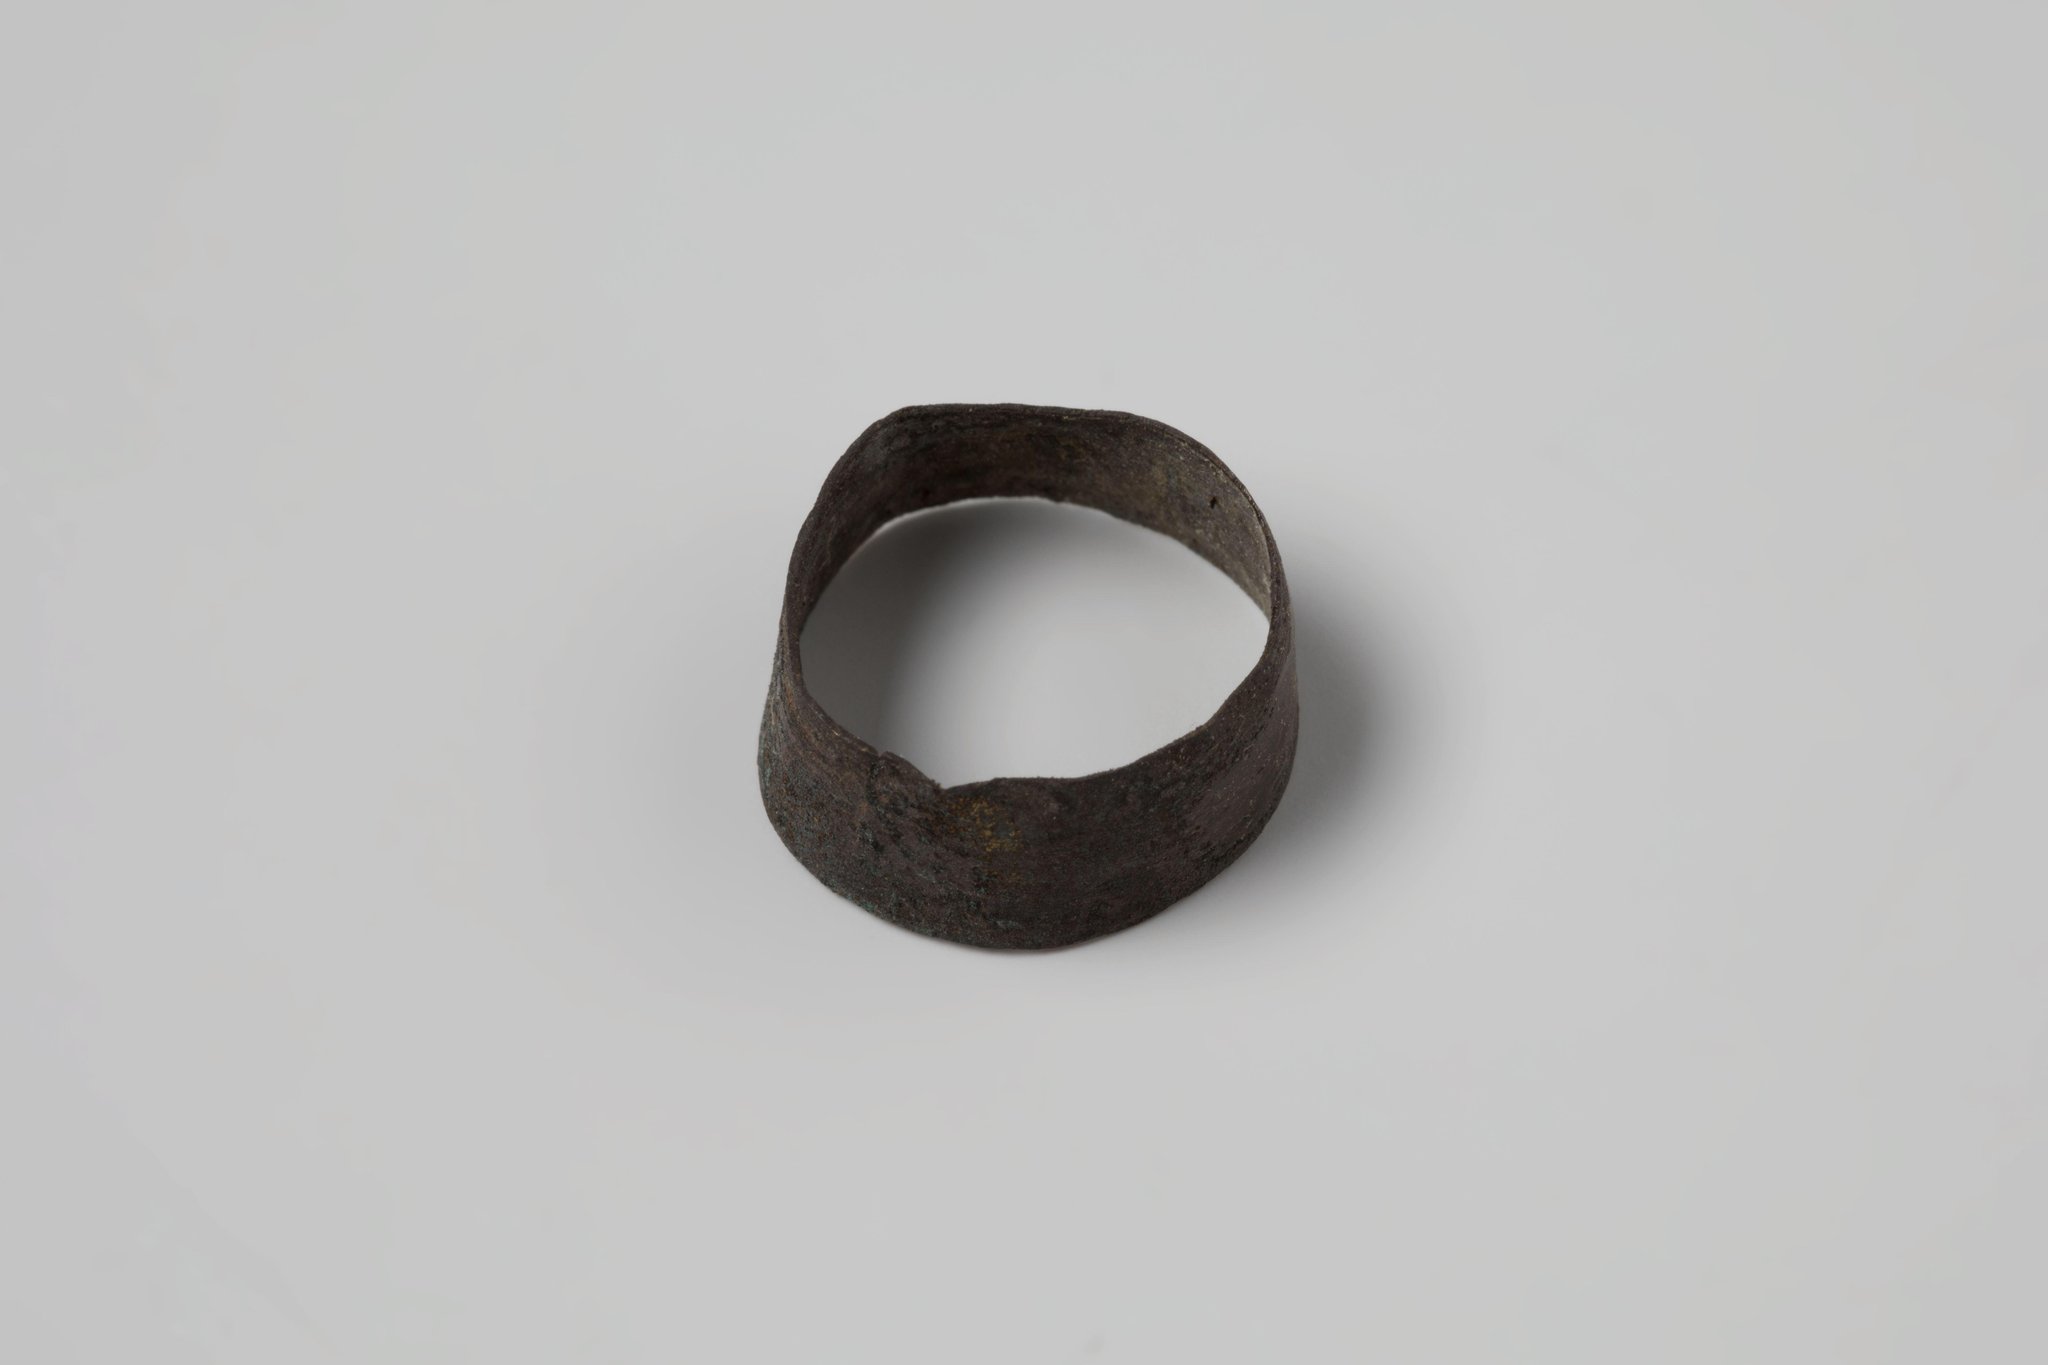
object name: ferrule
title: Messenheftring uit het wrak van de Oost-Indiëvaarder Hollandia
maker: Anonymous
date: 1700-1743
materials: copper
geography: netherlands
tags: verenigde oostindische compagnie, hollandia (schip), annet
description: Knife-handle, ferrule; (1) id. NG 1980-27H426.